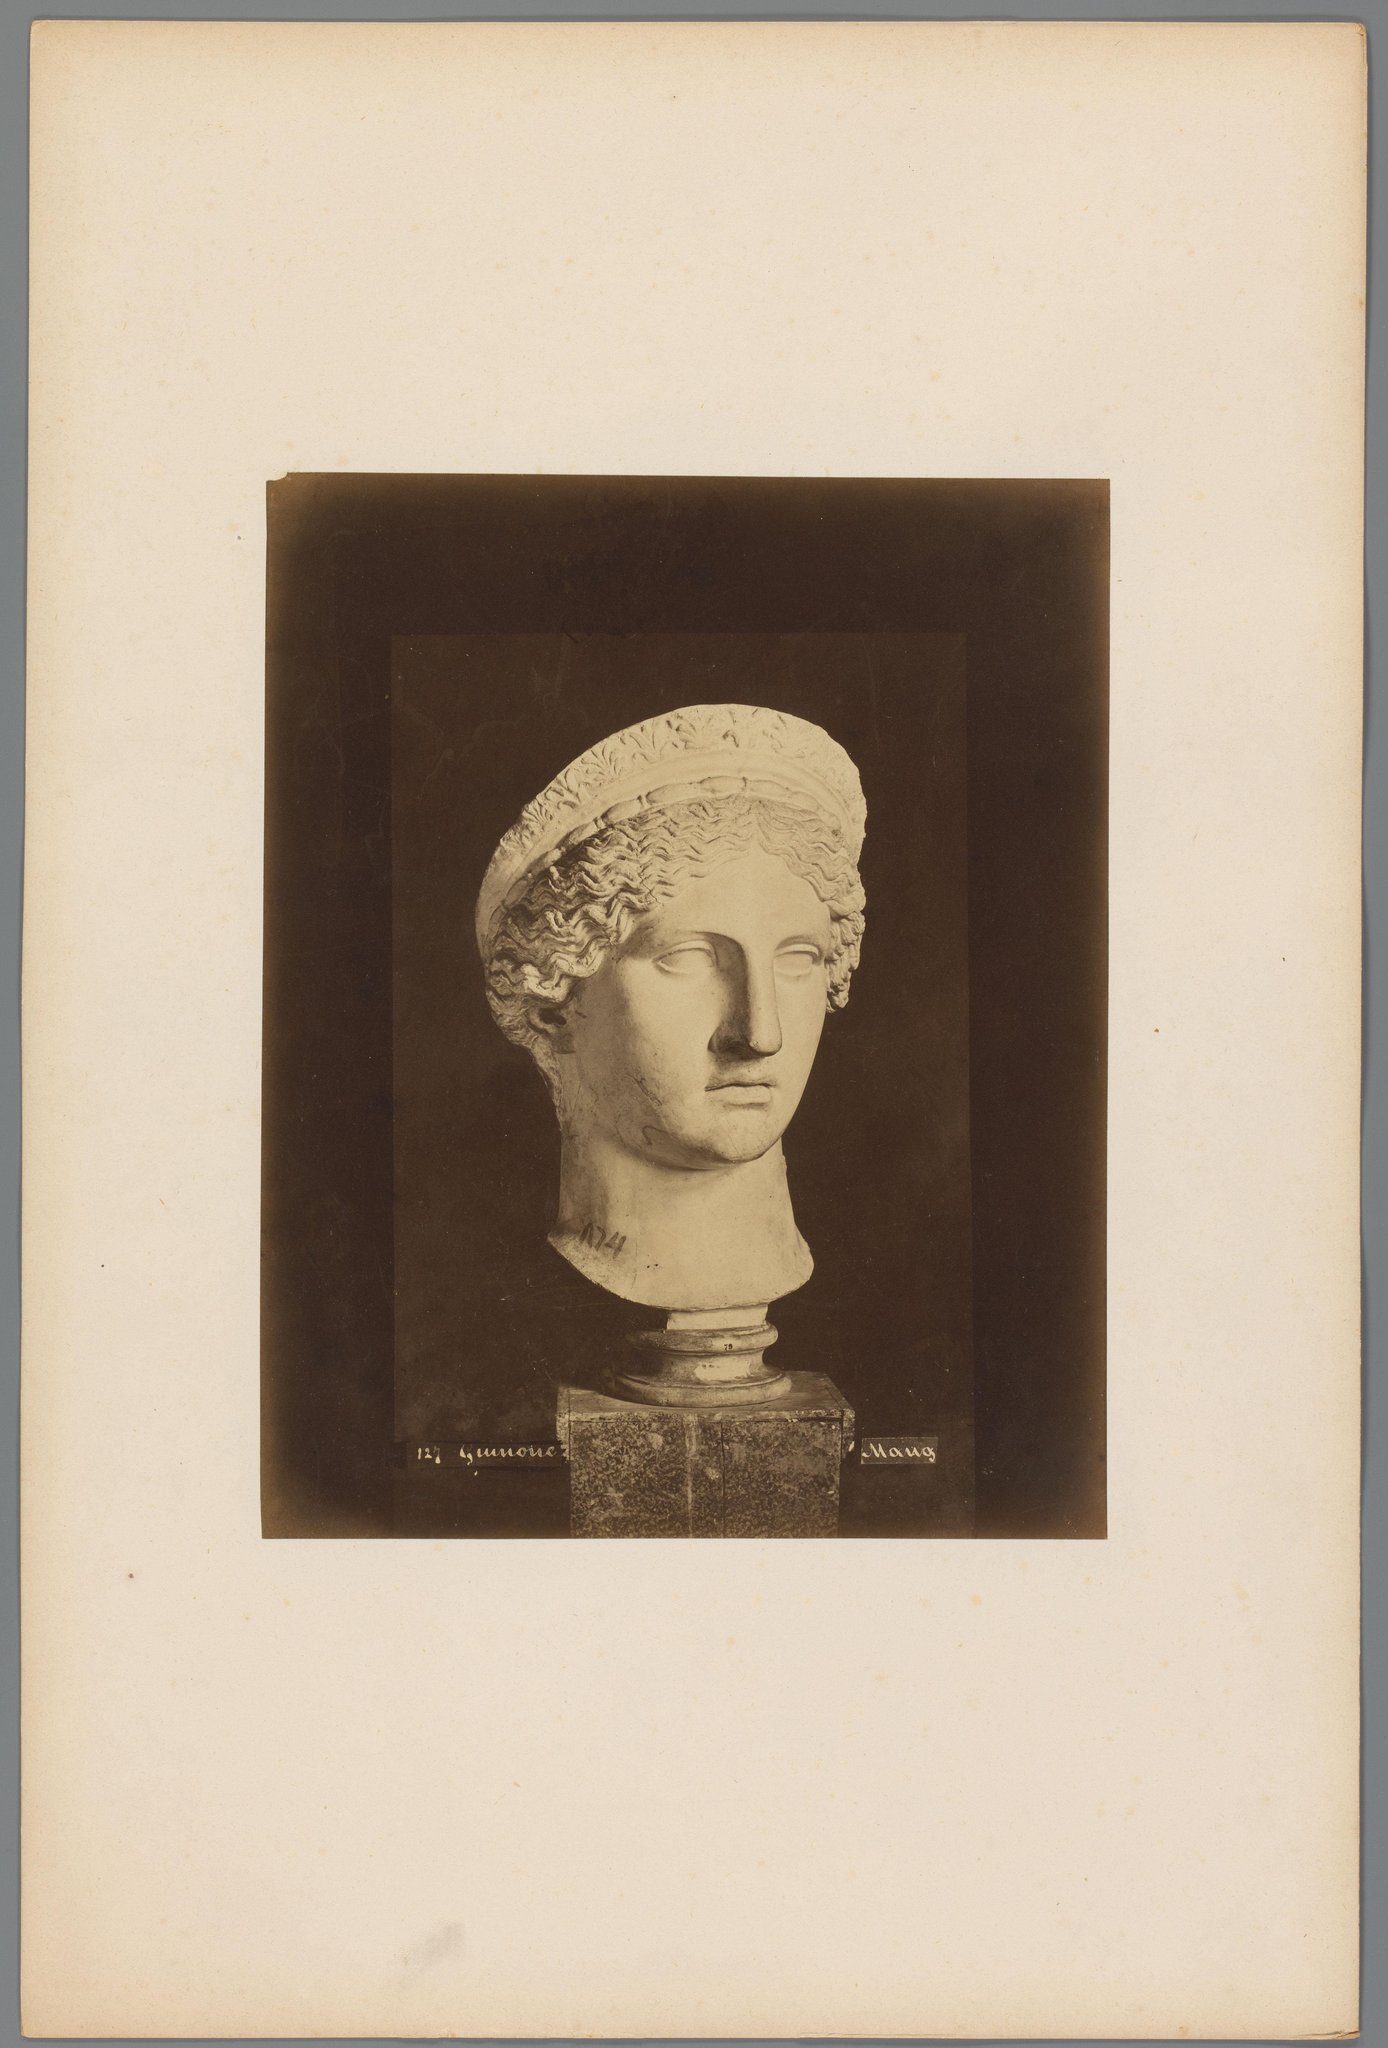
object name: photograph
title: Buste van een vrouw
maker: michèle mang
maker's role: fotograaf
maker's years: 1840-1909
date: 1863-1887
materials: cardboard, paper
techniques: albumen print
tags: head (human), piece of sculpture, reproduction of a piece of sculpture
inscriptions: number: ‘127’